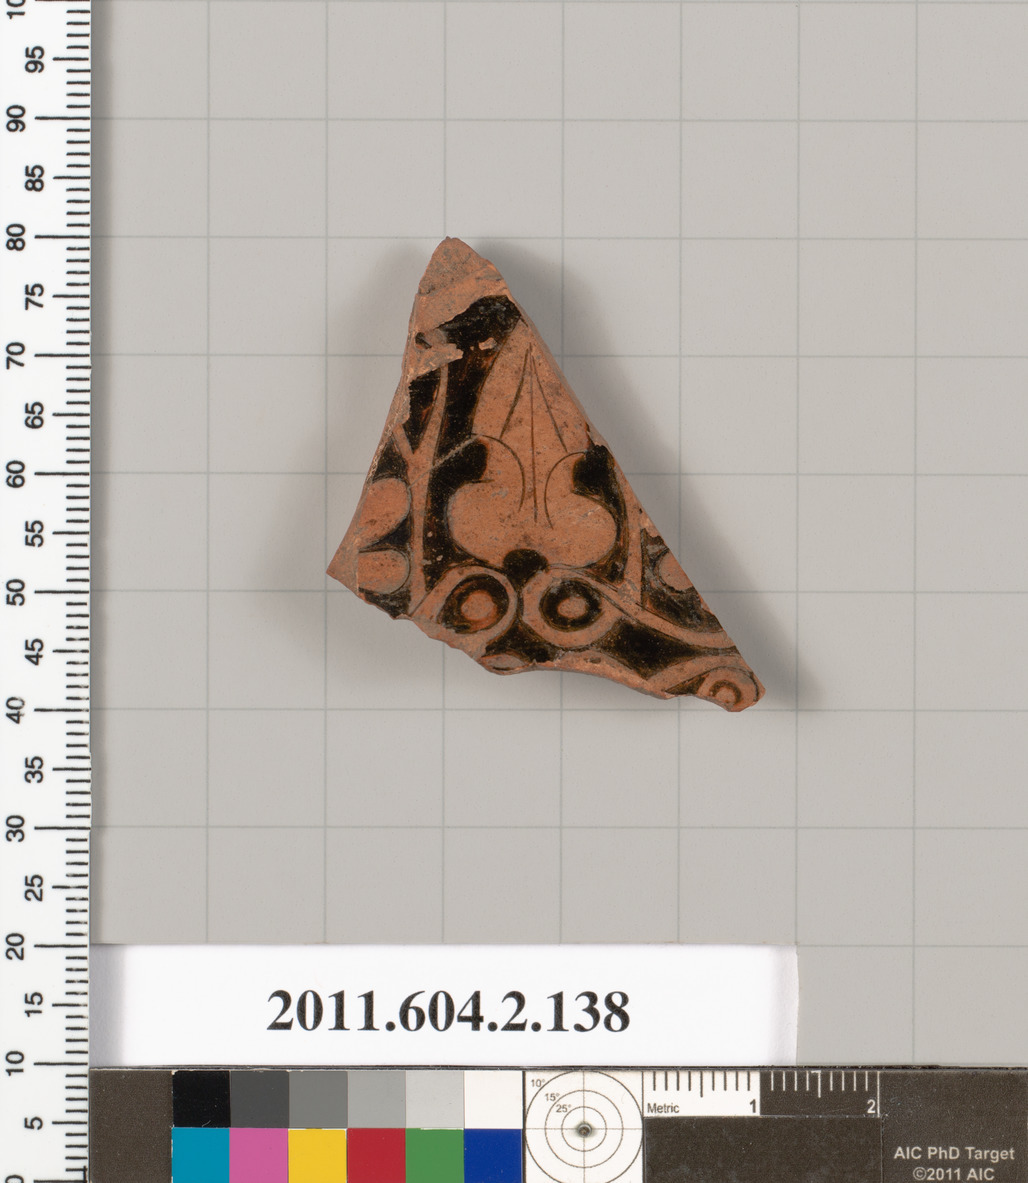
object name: pelike fragment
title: Terracotta fragment of a pelike (jar)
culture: greek, attic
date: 500-480 BCE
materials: terracotta